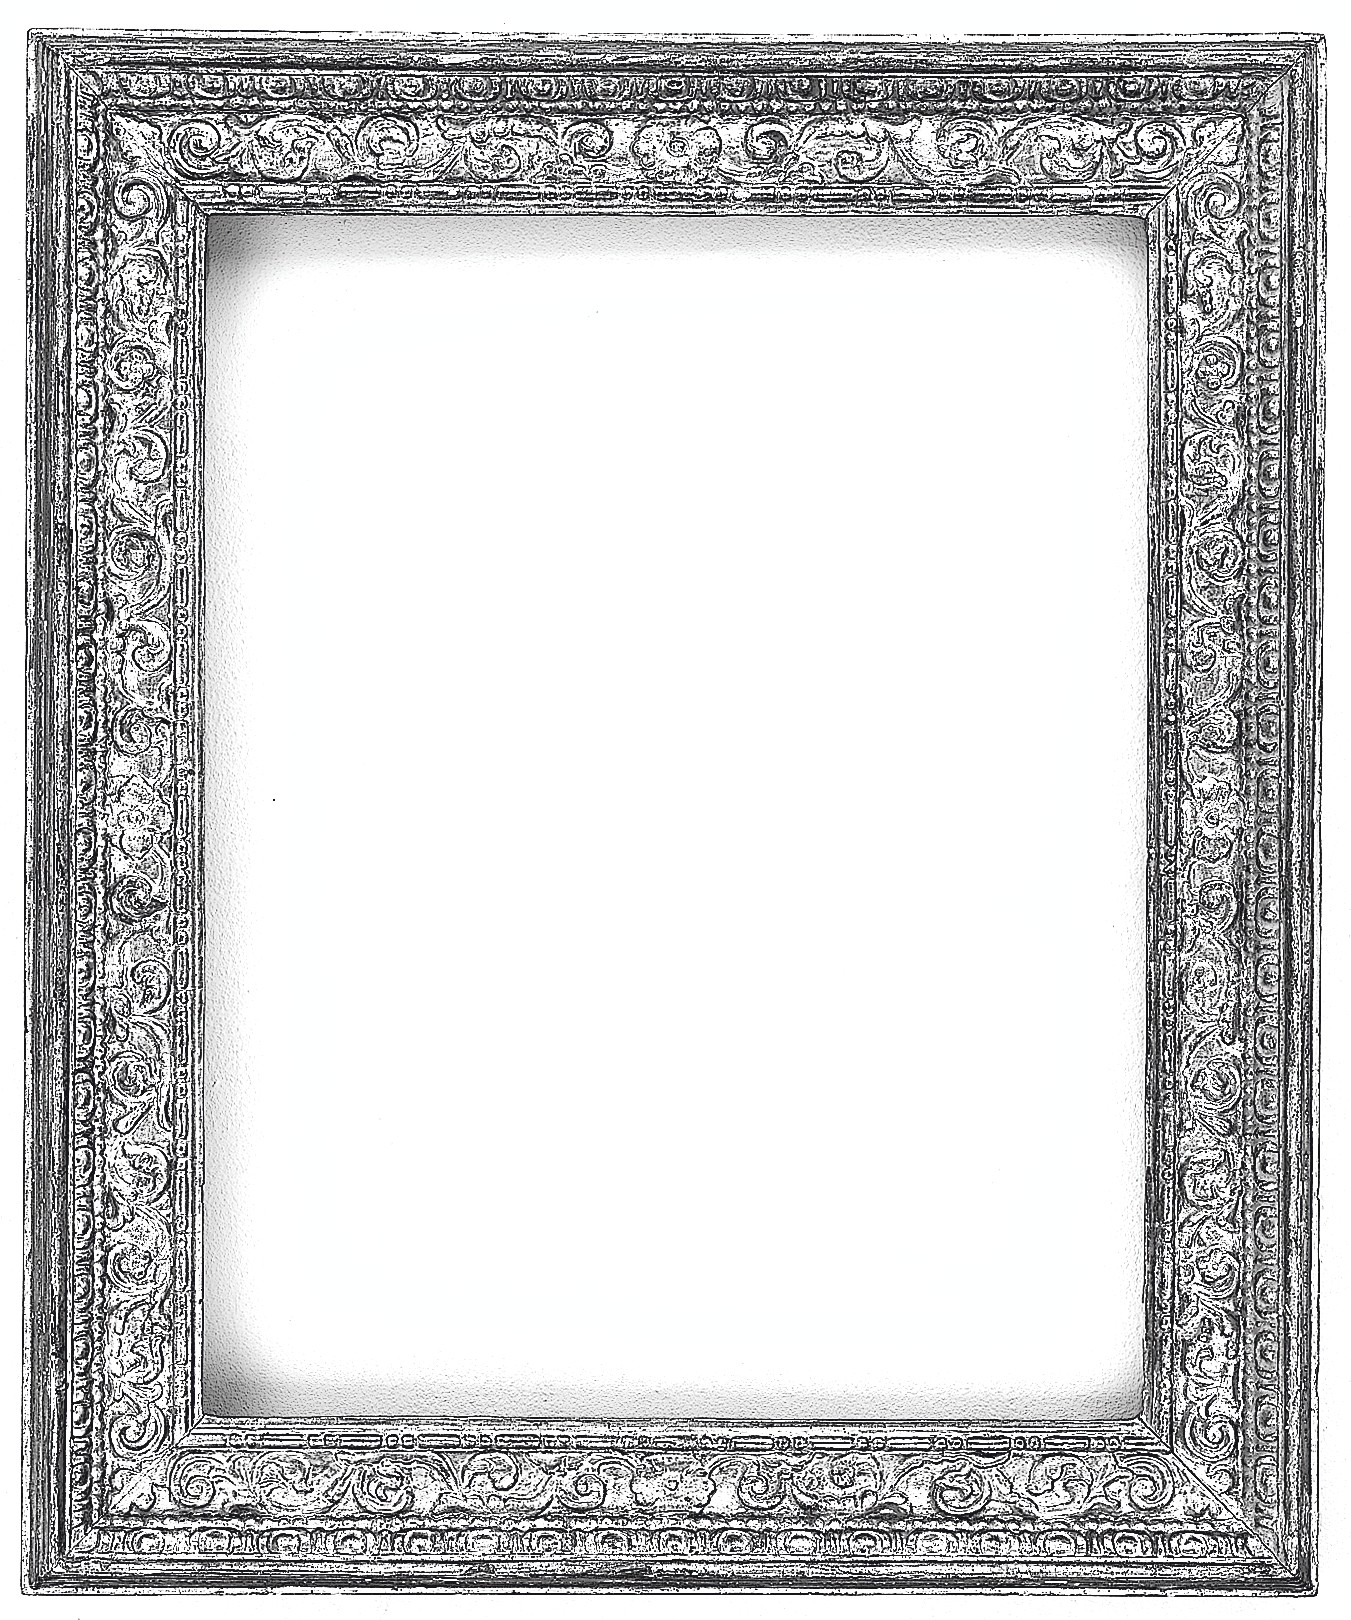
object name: frame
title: Cassetta frame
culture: italian, veneto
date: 1767-1800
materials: wood